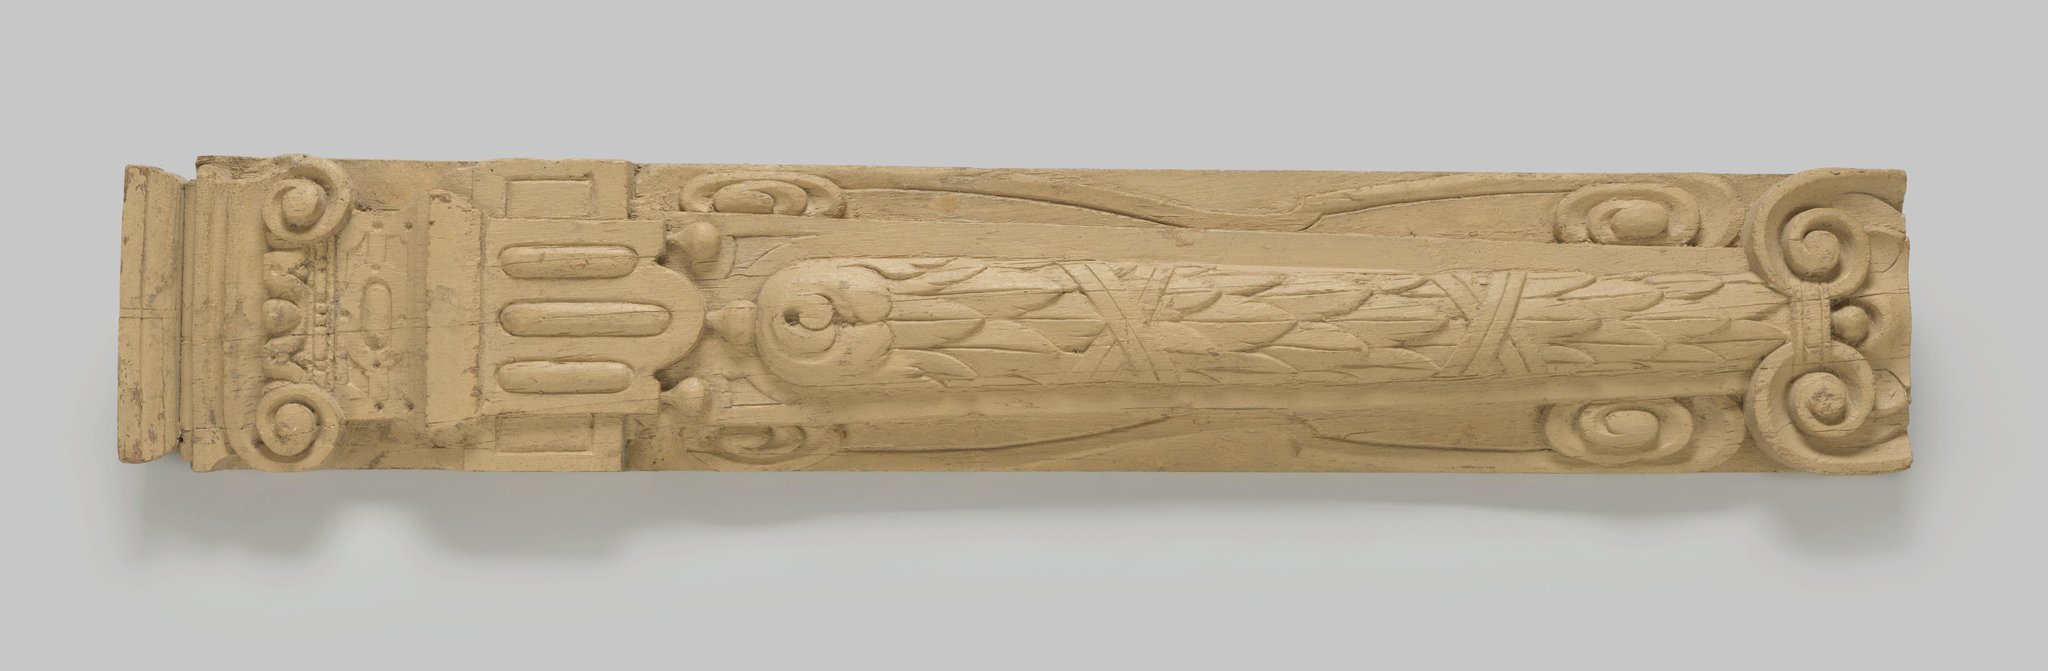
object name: stile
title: Gedeelte van een gebeeldhouwde stijl van eikenhout, afkomstig uit het z.g. Huis van Alva, Warmoestraat te Amsterdam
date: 1500-1699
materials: wood, paint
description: Gedeelte van gebeeldhouwde eikenhouten stijl (behorend bij BK-KOG-754-7), afkomstig uit het z.g. Huis van Alva, Warmoestraat te Amsterdam. In totaal gaat het om zes beschilderde stijlen (zie BK-KOG-754-1 t/m 5 & 7). Zie tevens BK-KOG-755-A t/m H, dit zijn twee kapitelen en zes stijlen van onbehandeld eikenhout die uit hetzelfde huis afkomstig zijn.